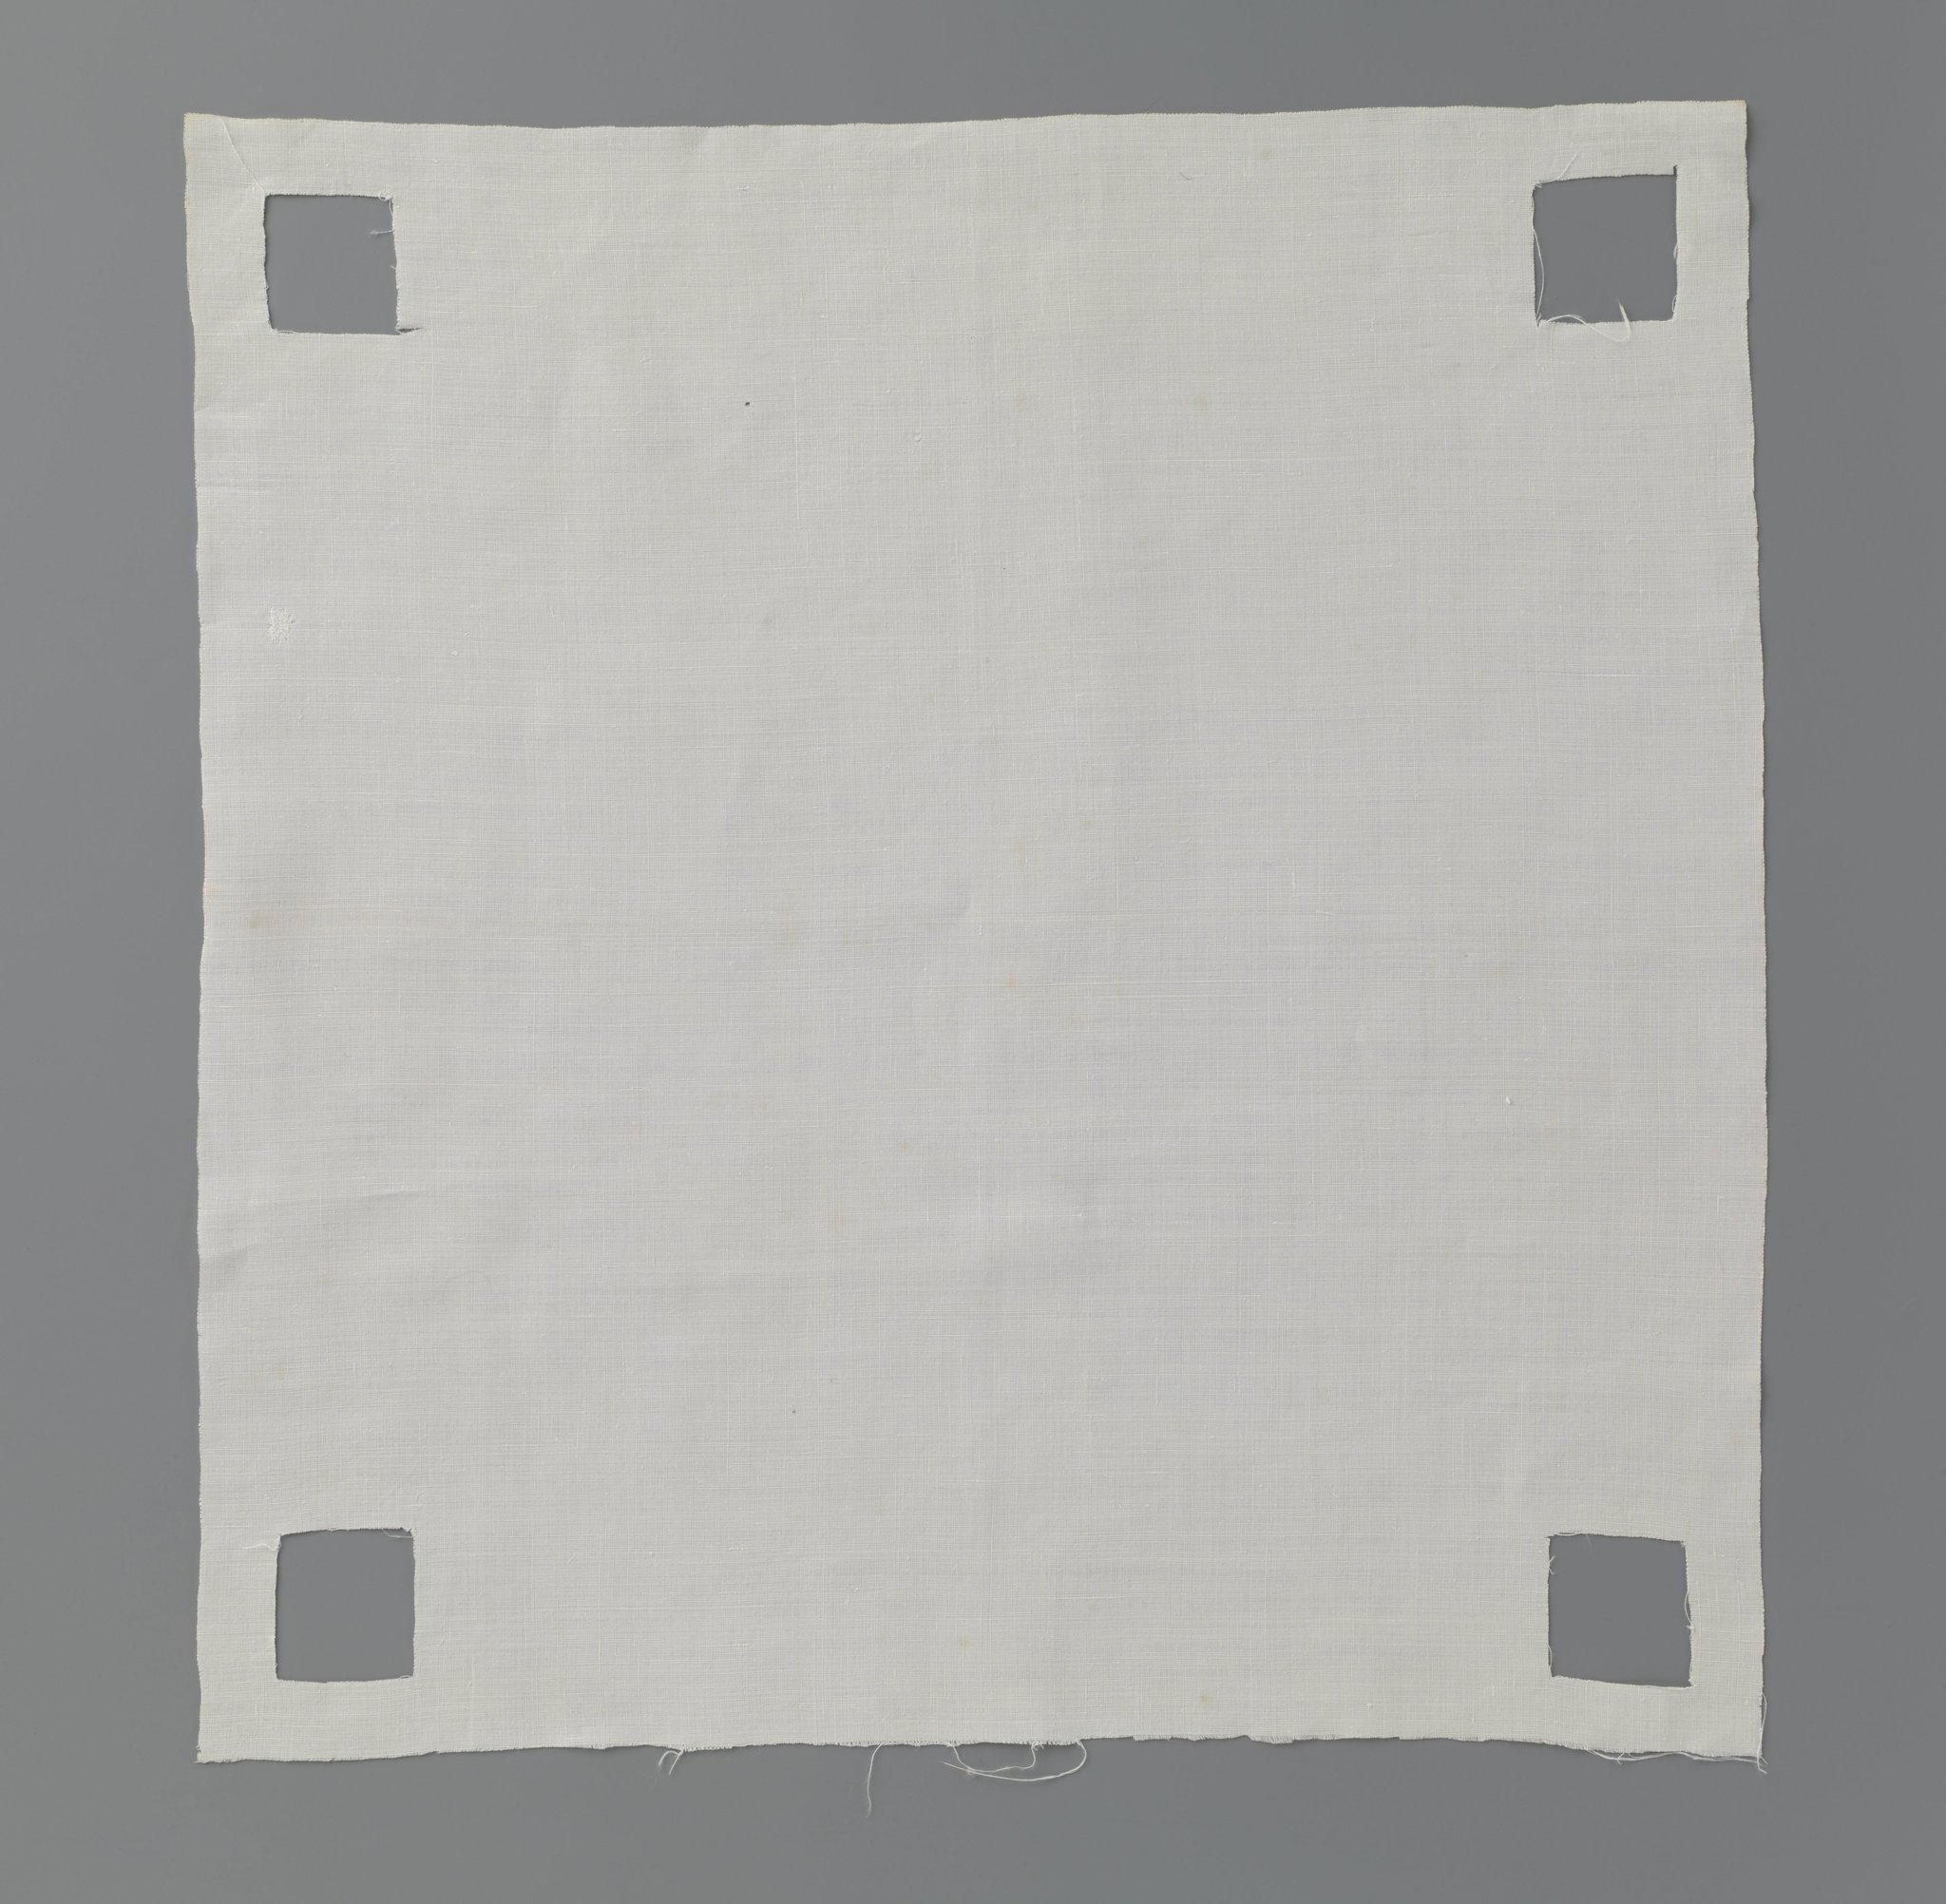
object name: fragment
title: Gescheurd, linnen middenstuk van zakdoek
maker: Anonymous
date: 1600-1699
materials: linen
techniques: weave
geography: netherlands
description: Linnen middenstuk geknipt uit zakdoek (BK-1973-124-A). Met bruine vlekken.